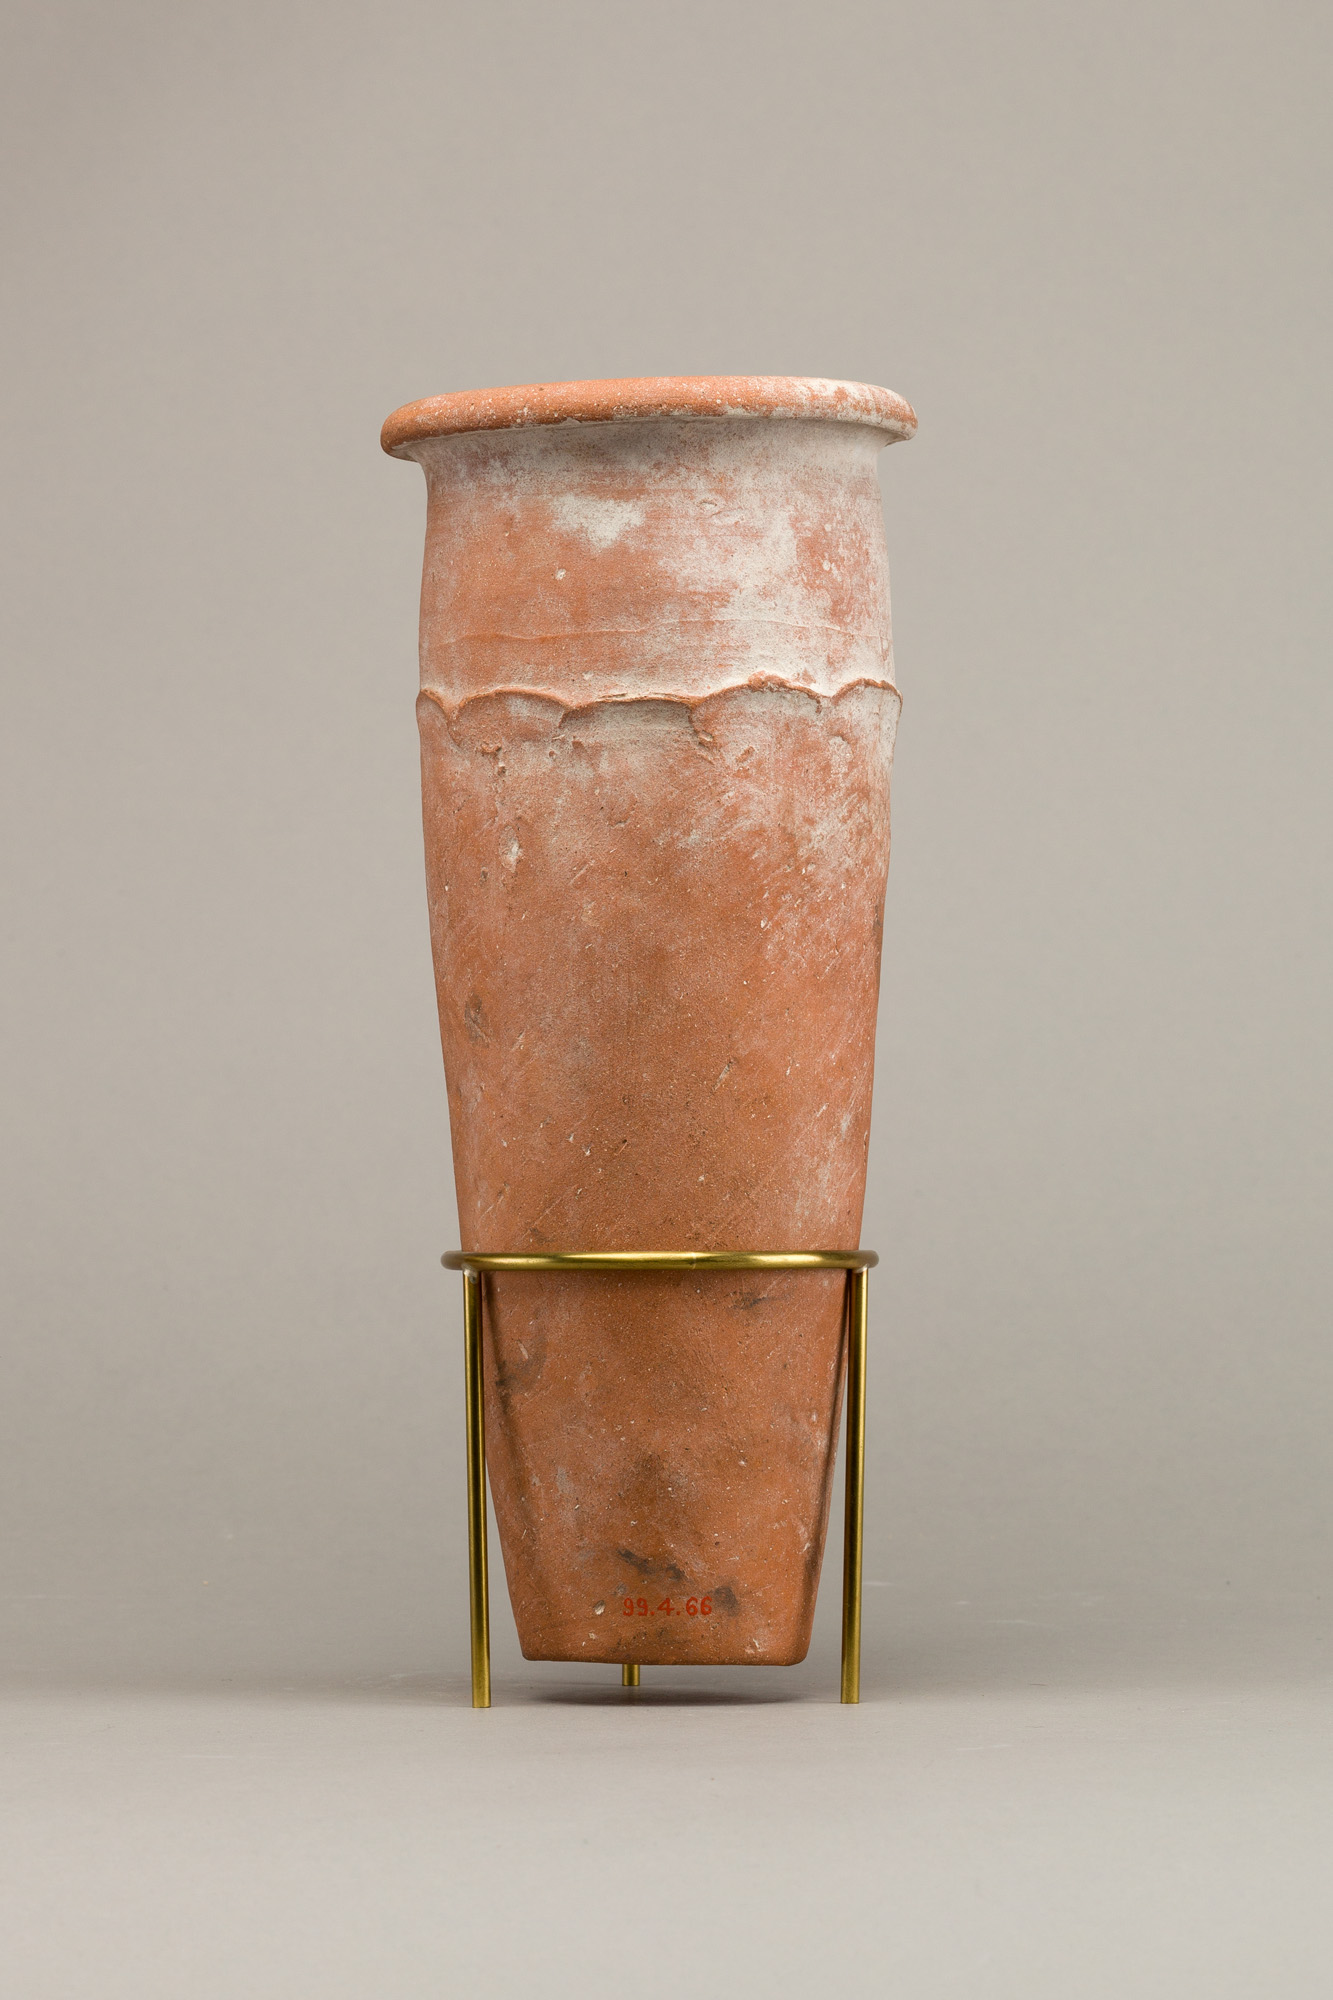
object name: jar, wavy handled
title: Wavy-handled jar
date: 3850-2960 BCE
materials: pottery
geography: egypt